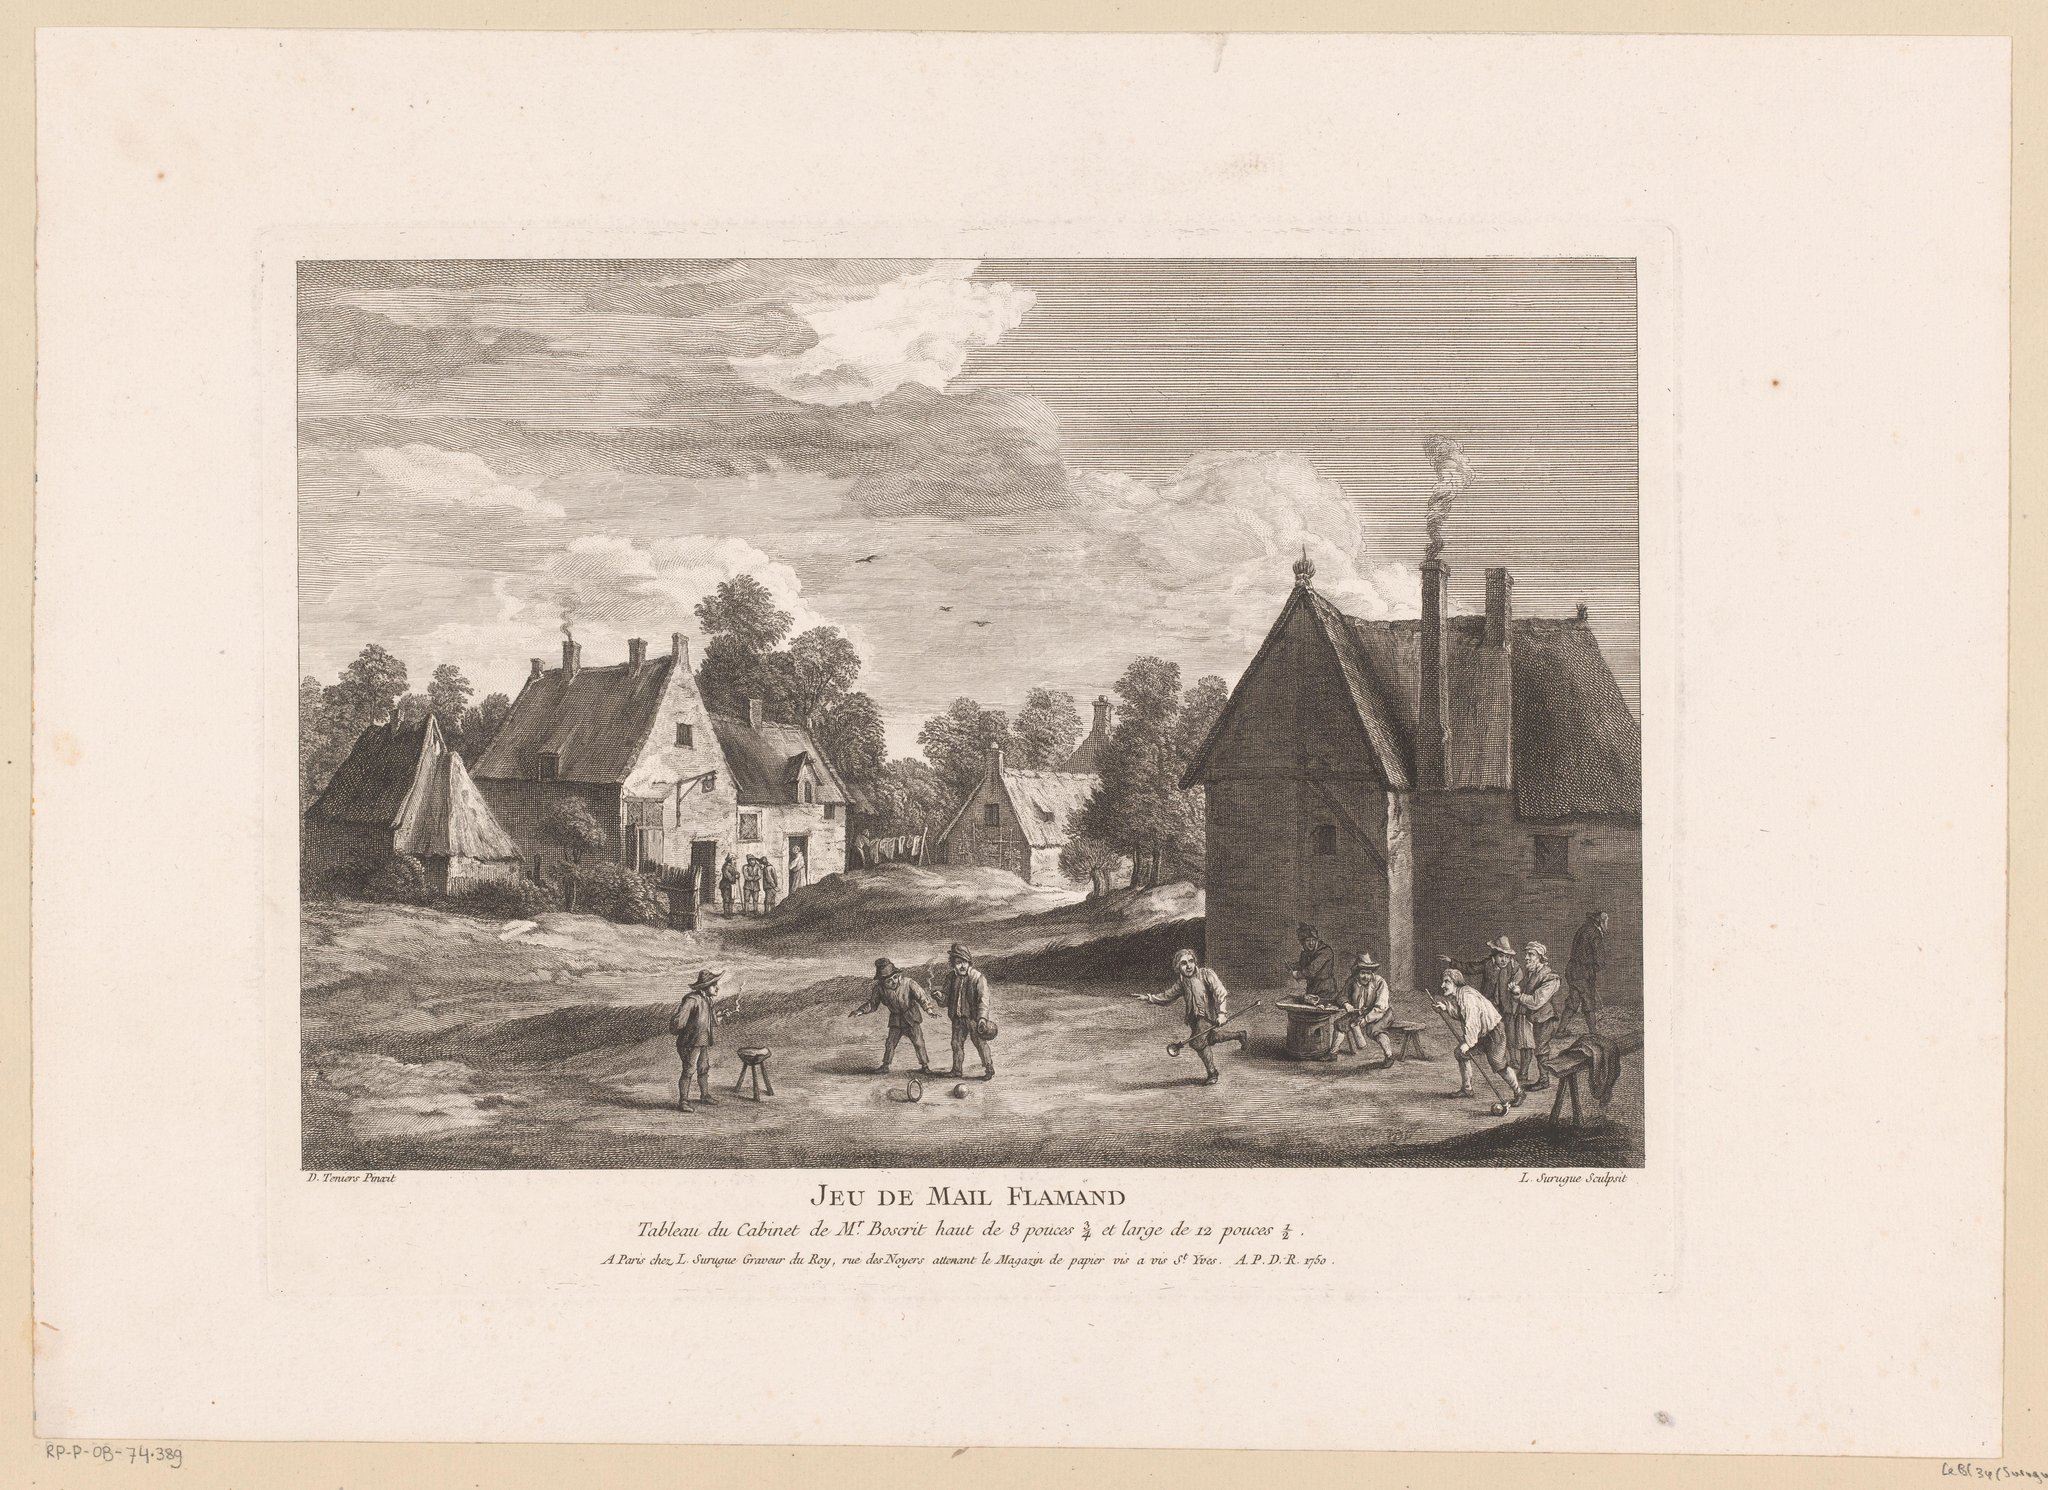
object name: print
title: Jeu de mail Flamand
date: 1750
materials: paper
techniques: engraving, etching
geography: france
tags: village, ball games in which ball is hit or knocked with stick (individual play)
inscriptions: collector's mark: Lugt 240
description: Mannen die een spel genaamd klossen of beugelen spelen.